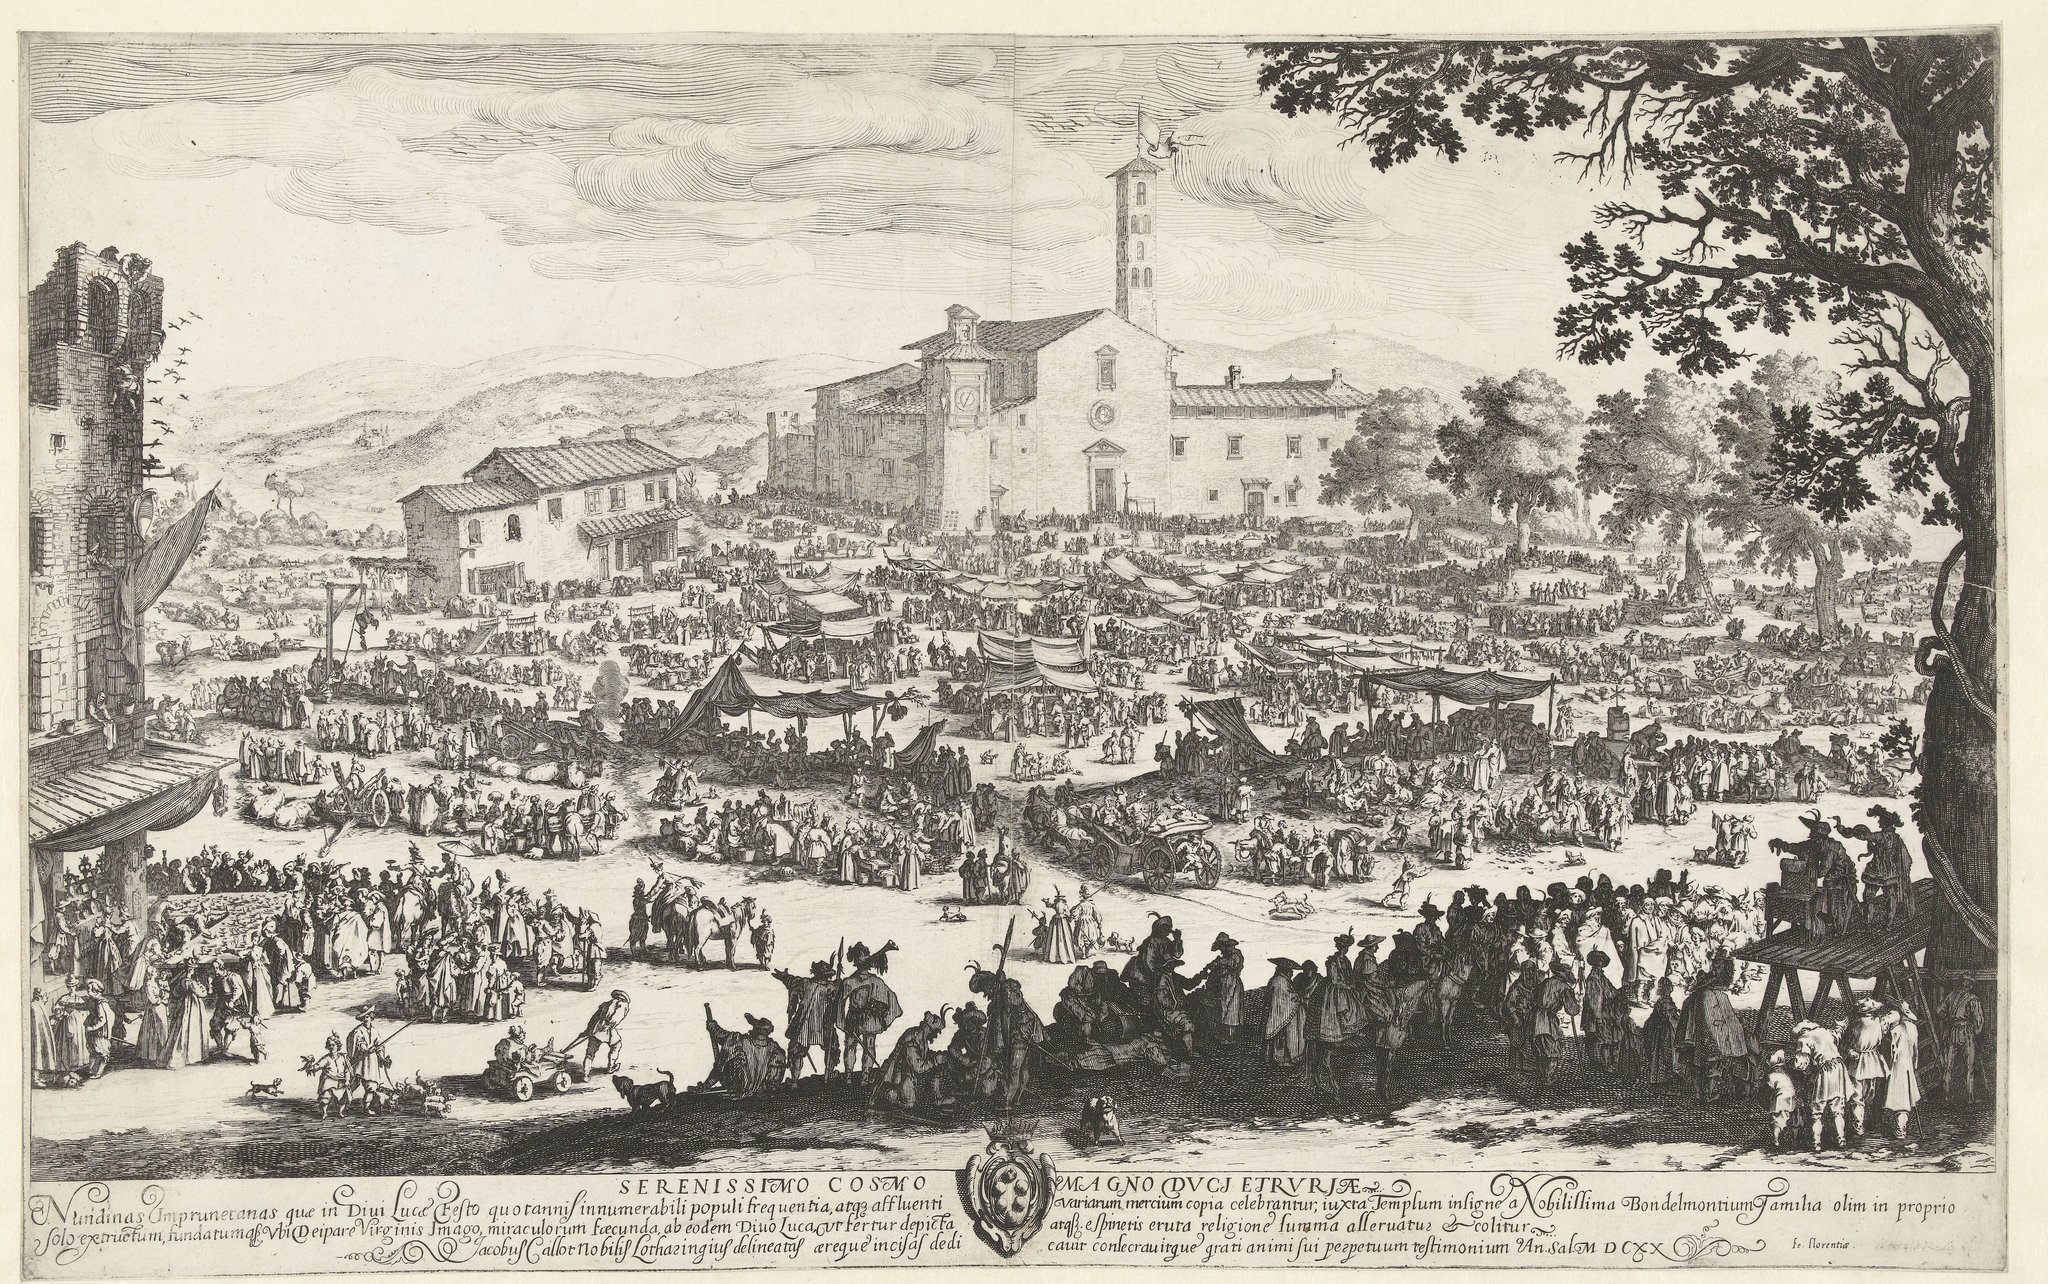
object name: print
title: La Foire d'Impruneta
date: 1622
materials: paper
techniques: engraving, etching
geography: nancy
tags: cosimo ii de' medici, (annual) fair, trade fair, village square, place, armorial bearing, heraldry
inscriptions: collector's mark: Lugt 240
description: Jaarmarkt op 18 oktober te Impruneta, een dorp nabij Florence: een grote menigte kraampjes, handelaren en bezoekers op een plein voor een kerk. Middenonder het wapen van de Medici. Onder de voorstelling een onderschrift in Latijn.